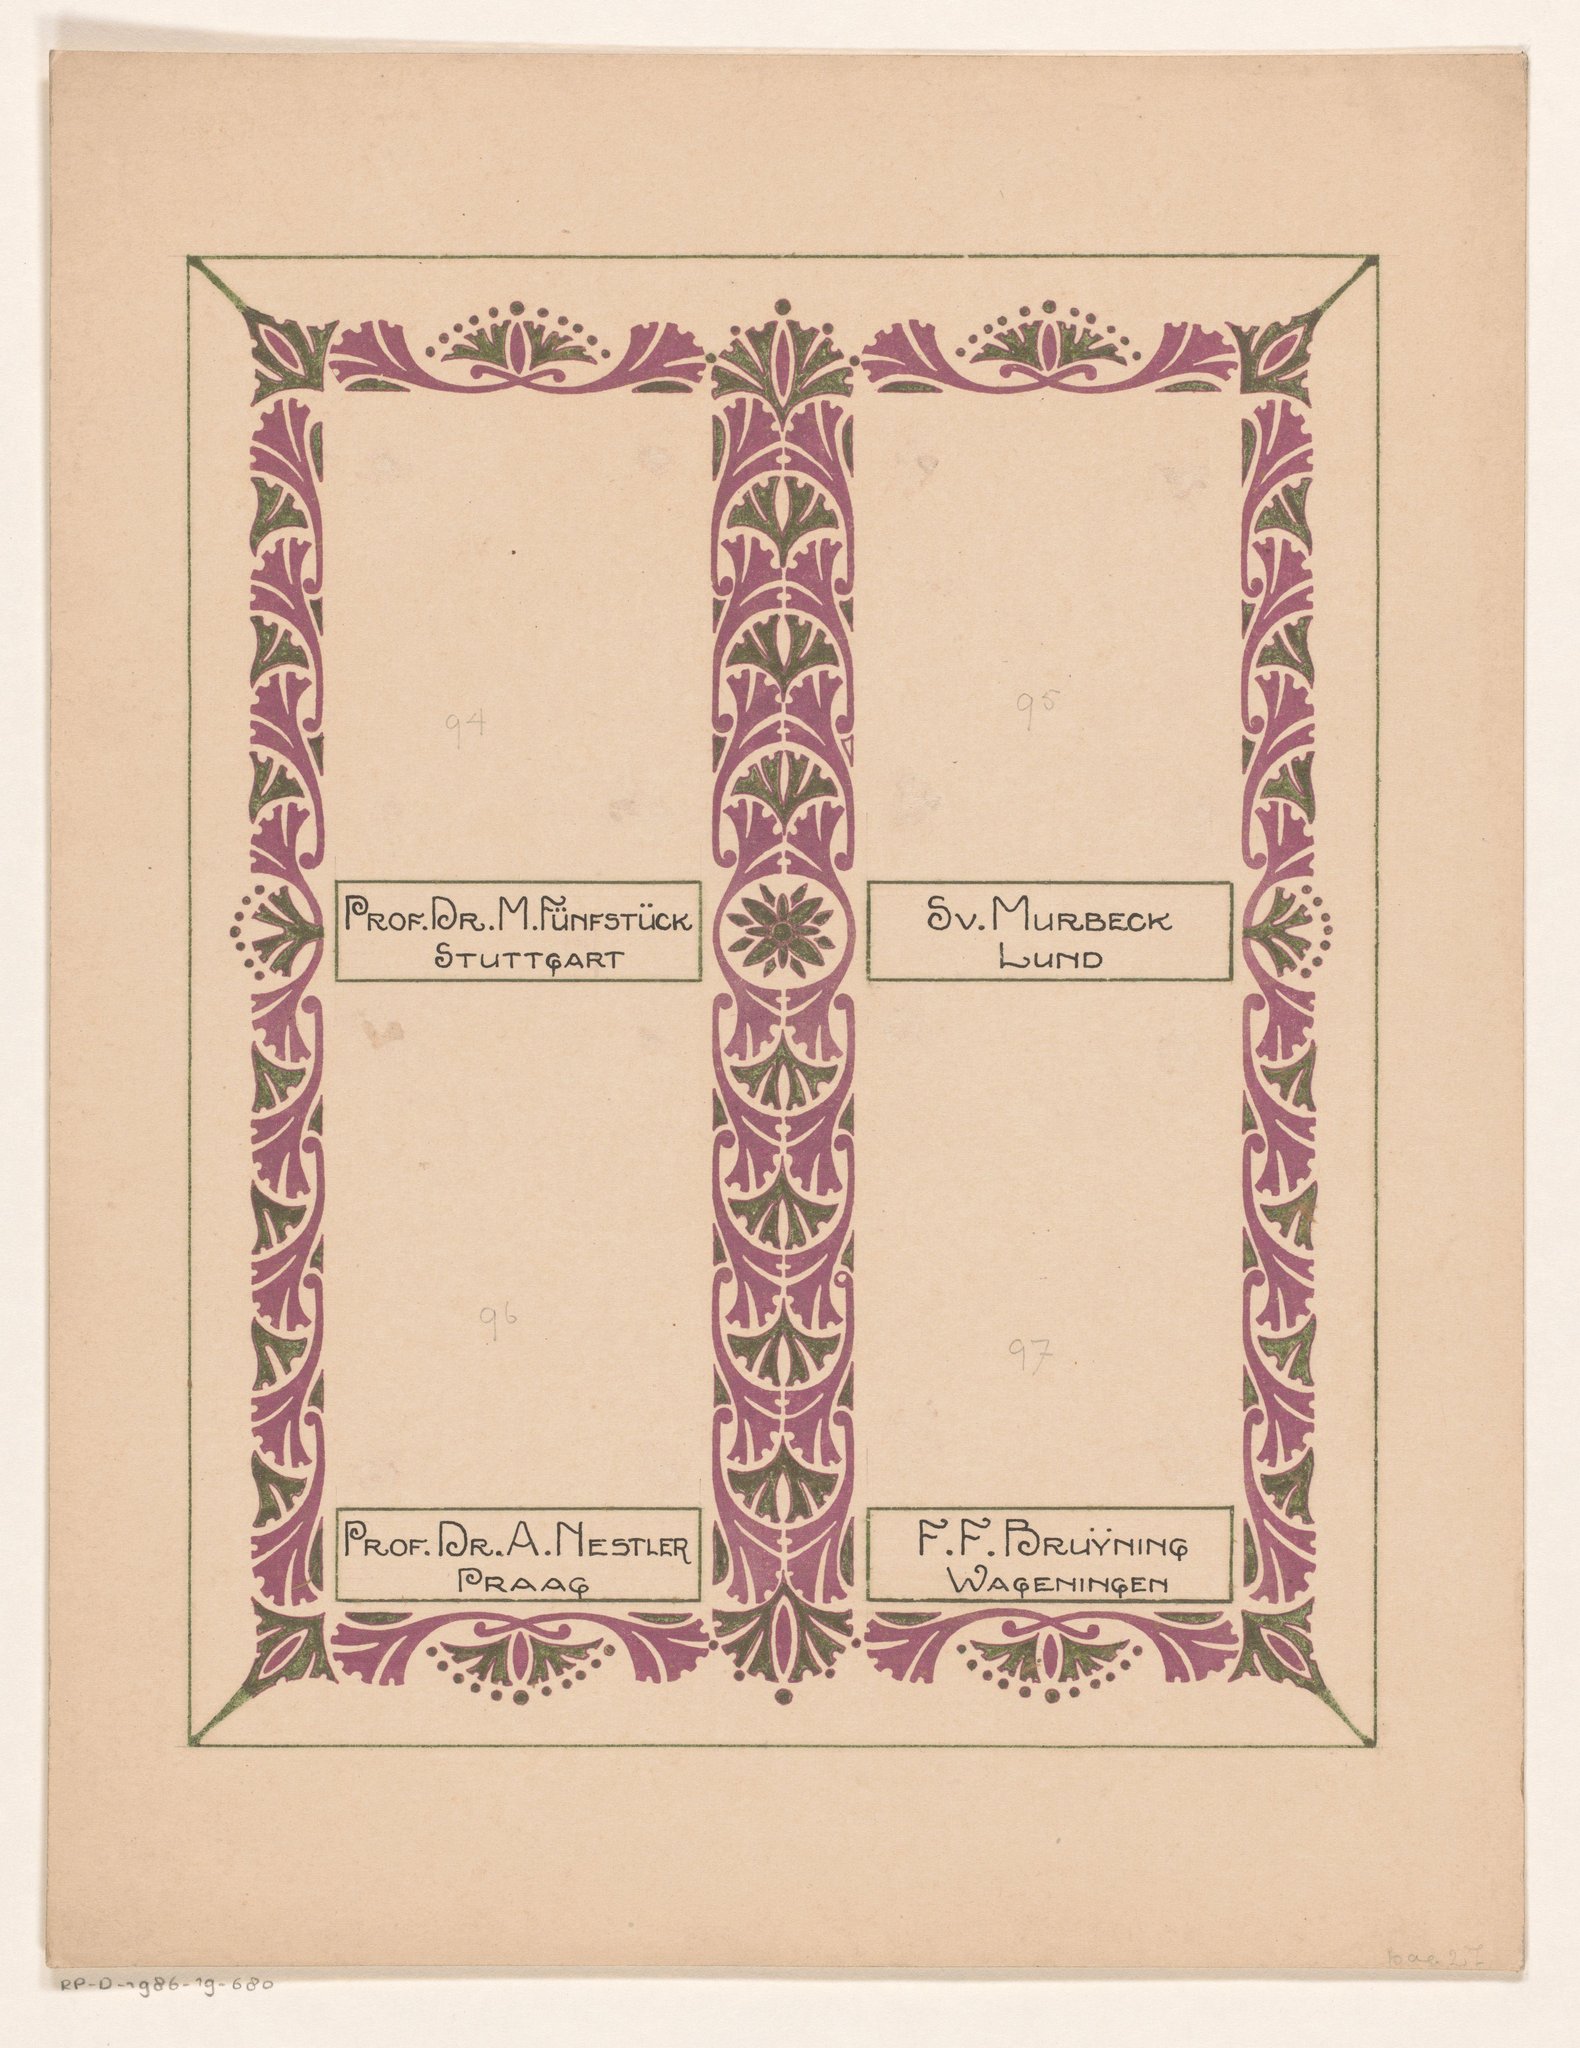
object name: print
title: Albumblad voor een album voor Prof. Hugo de Vries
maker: reinier willem petrus de vries (1874-1953)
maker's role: draughtsman, print maker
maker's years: 1874-1953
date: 1918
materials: paint, ink, paper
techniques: brush, lithograph, pen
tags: haarlem, hugo de vries, flowers ~ ornament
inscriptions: collector's mark: ‘R:MVS.’, annotation: ‘pag 27’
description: Rechthoekig kader met bloem- en bladornamenten met daarin vier vakken voor portretten met onder elk vak de naam van de geportretteerde.